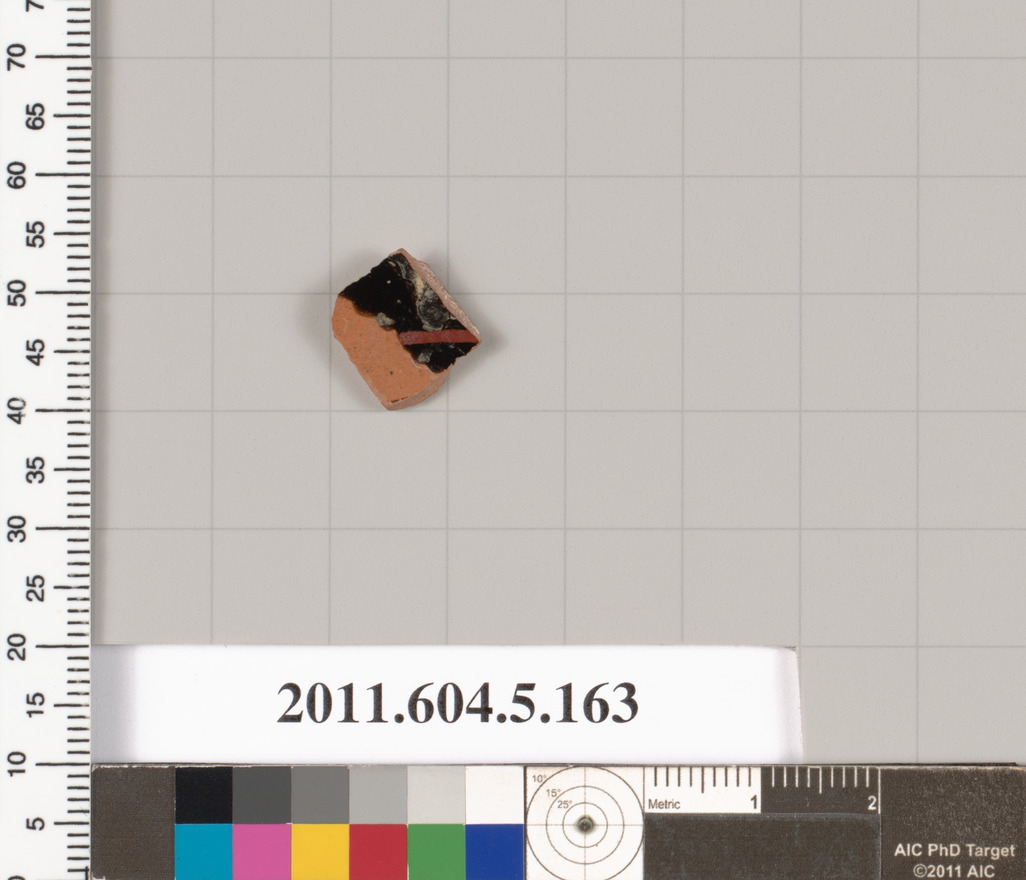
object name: kylix fragment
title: Terracotta fragment of a kylix (drinking cup)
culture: greek, attic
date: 600-401 BCE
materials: terracotta